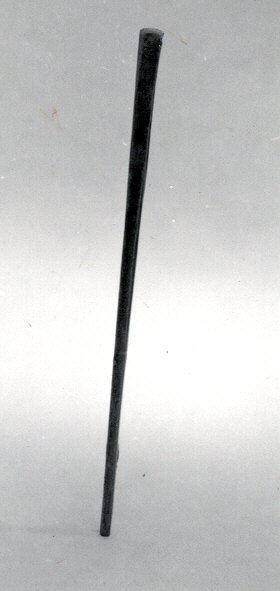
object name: chisel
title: Gold Chisel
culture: peruvian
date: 701-1600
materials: gold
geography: peru